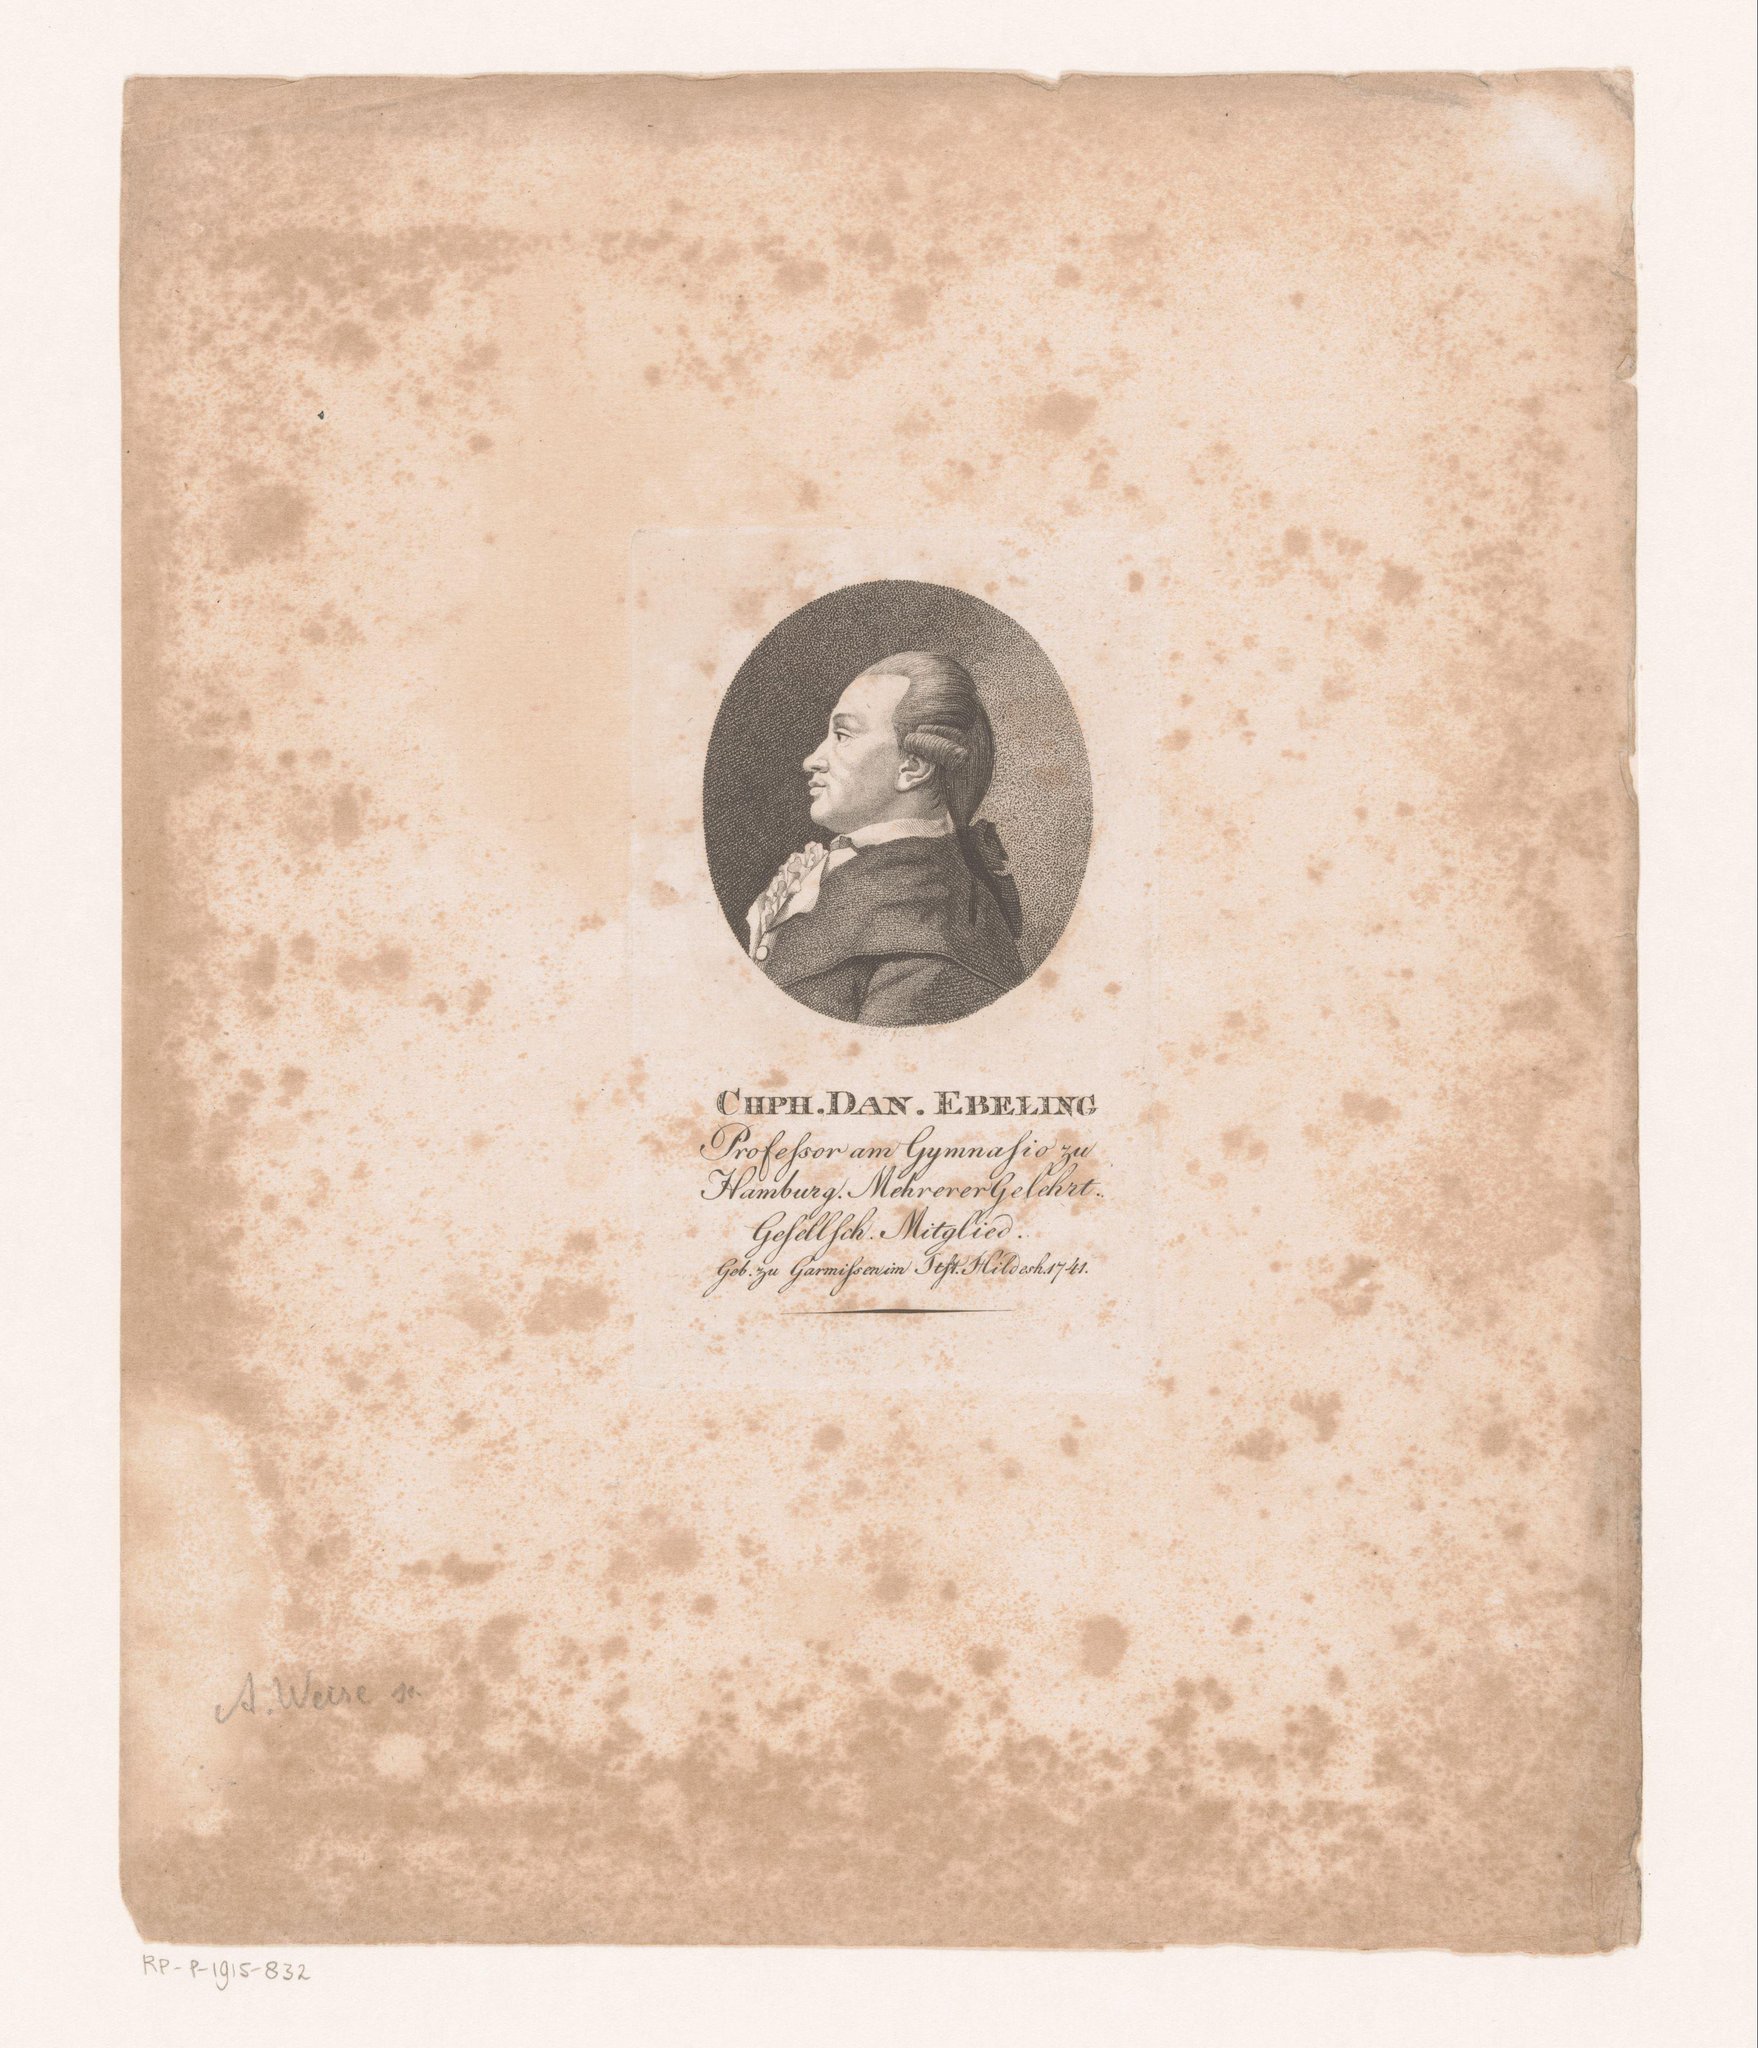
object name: print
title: Portret van Christoph Daniel Ebeling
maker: adam weise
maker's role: painter, print maker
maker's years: 1776-1835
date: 1786-1835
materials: paper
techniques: engraving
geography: germany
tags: historical persons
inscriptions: collector's mark: Lugt 2228